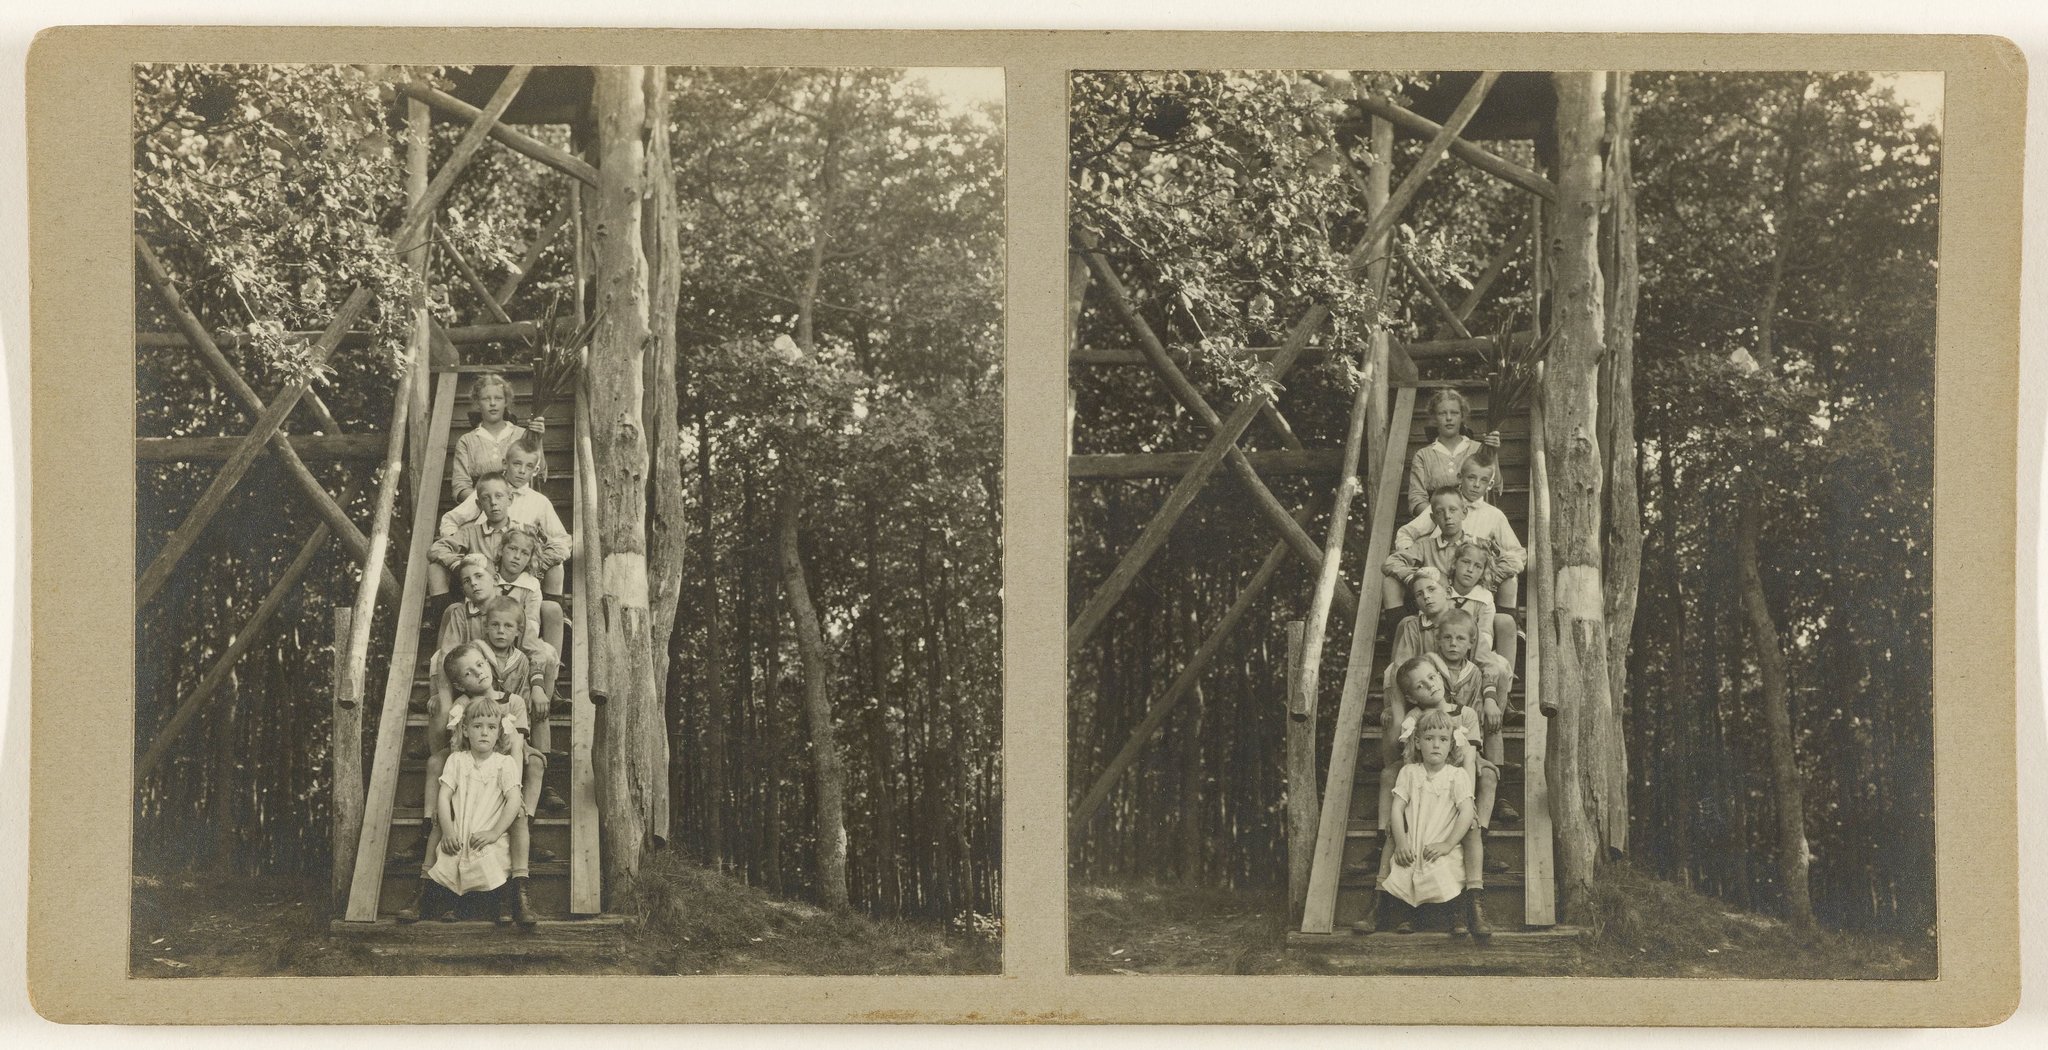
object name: stereograph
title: Groepsportret van acht kinderen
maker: e. ten cate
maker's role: fotograaf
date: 1908-1914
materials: cardboard, photographic support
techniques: gelatin silver print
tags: child between toddler and youth (of undetermined sex)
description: Acht kinderen, boven elkaar zittend op de treden van een houten toren in een bos.